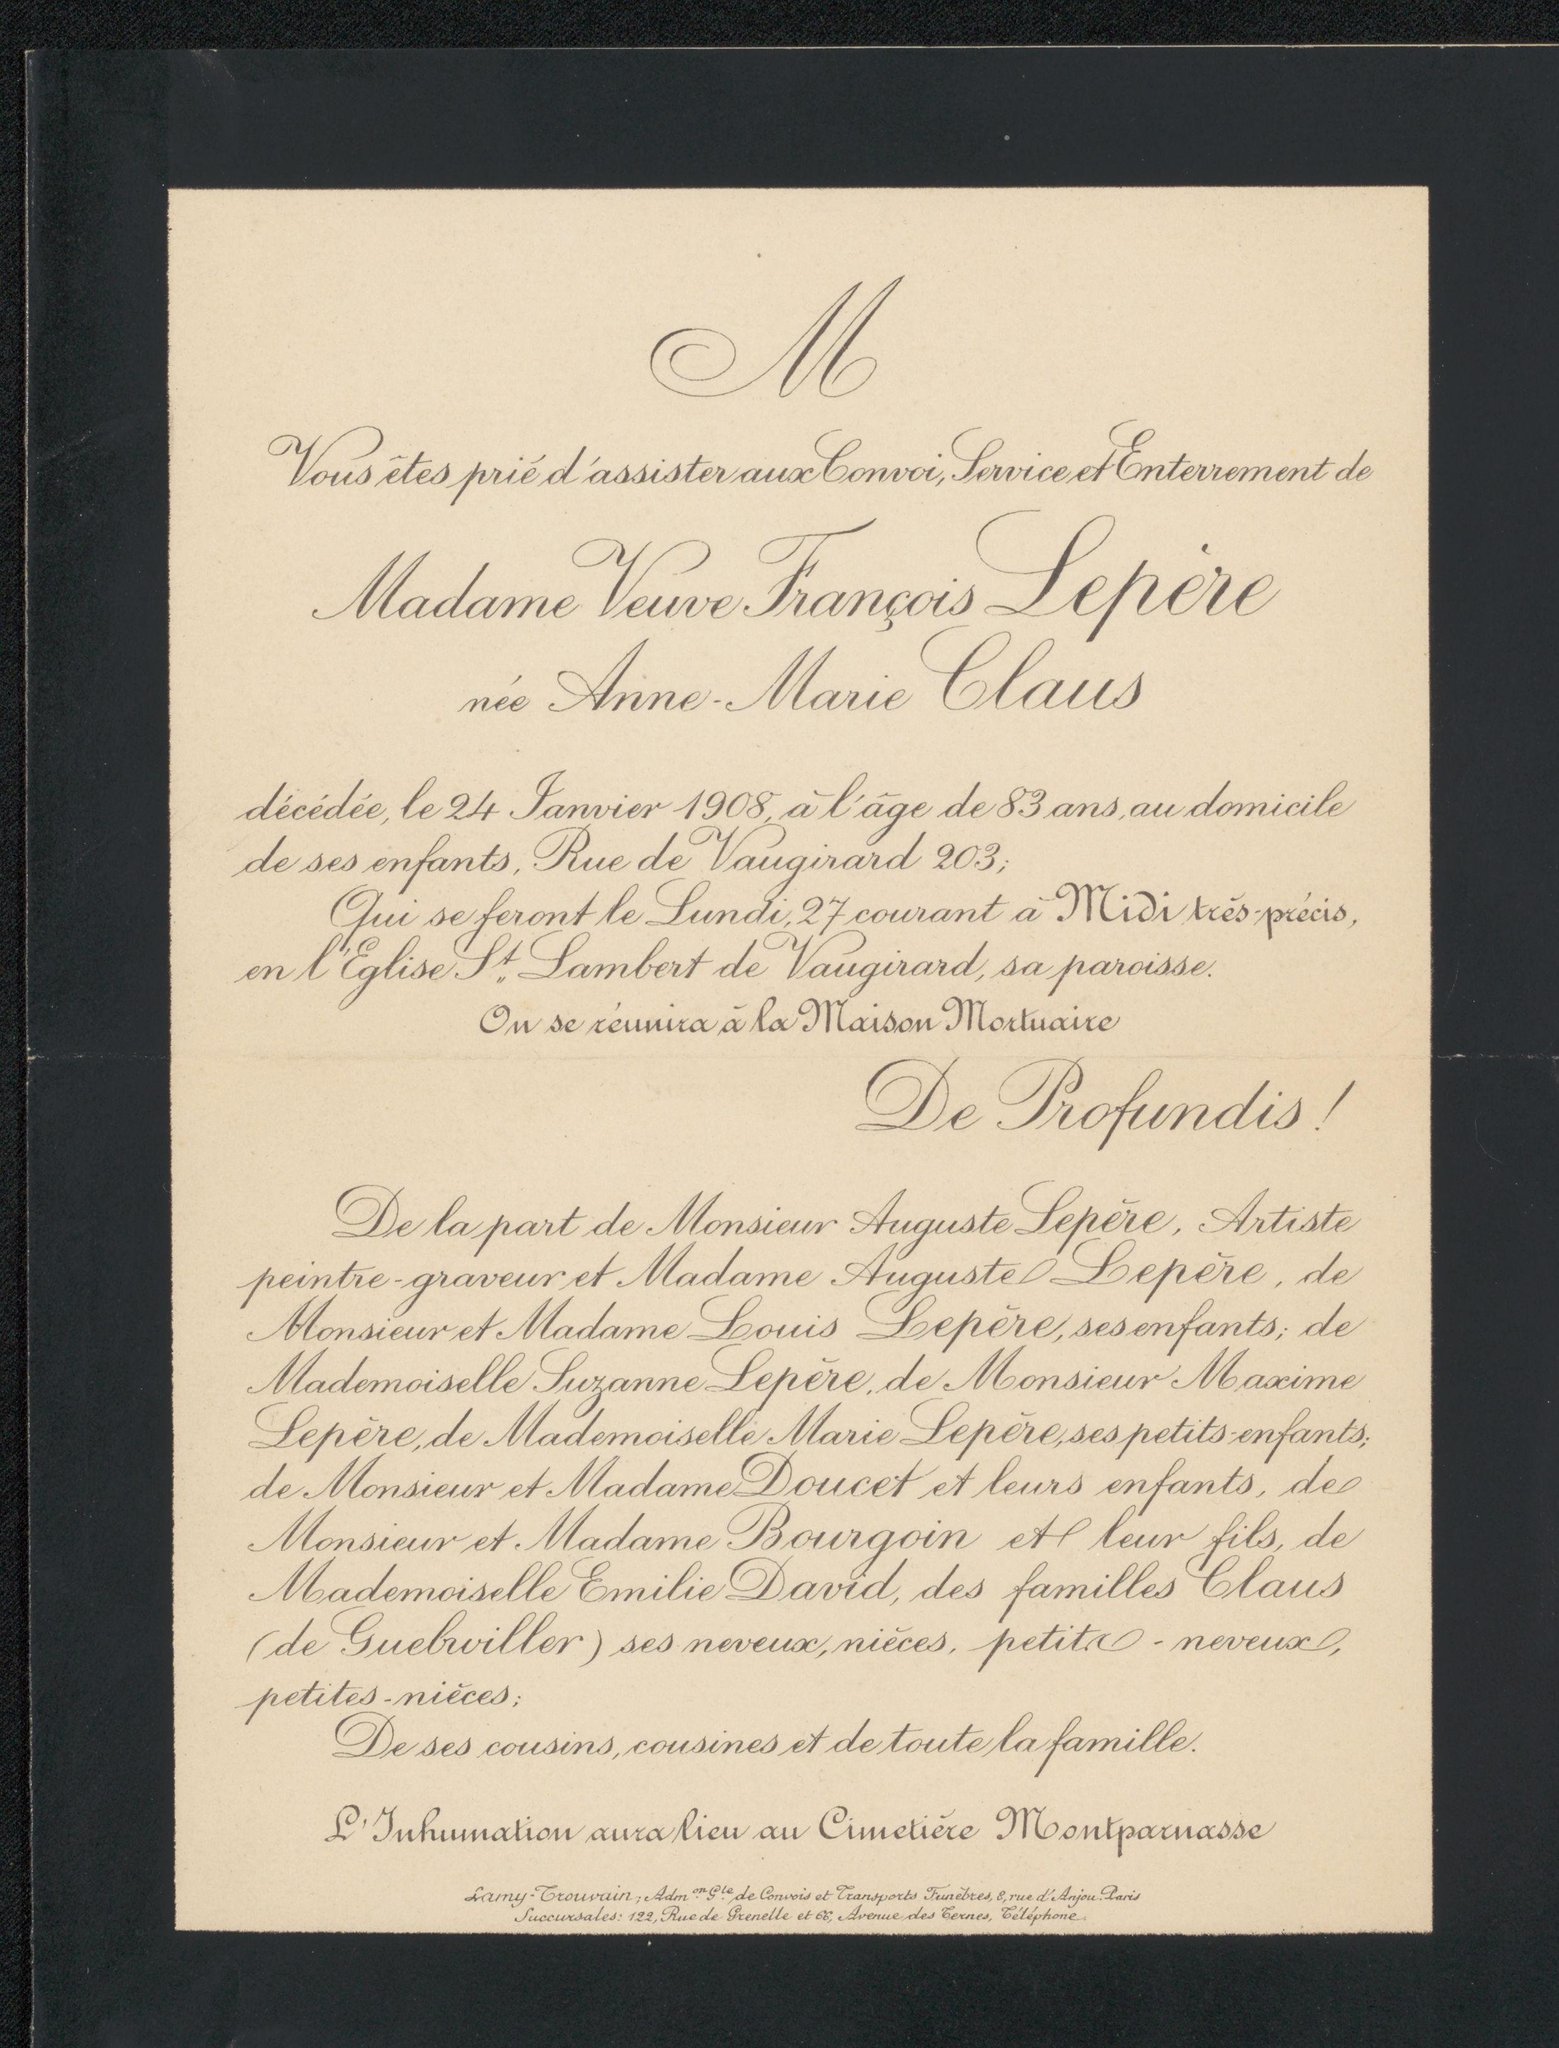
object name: overlijdensbericht, overlijdensadvertentie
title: Overlijdensbericht aan Philip Zilcken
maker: Anonymous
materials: paper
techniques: printing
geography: paris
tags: paris, the hague, painter, draughtsman, philip zilcken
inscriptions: collector's mark: ‘RPK’